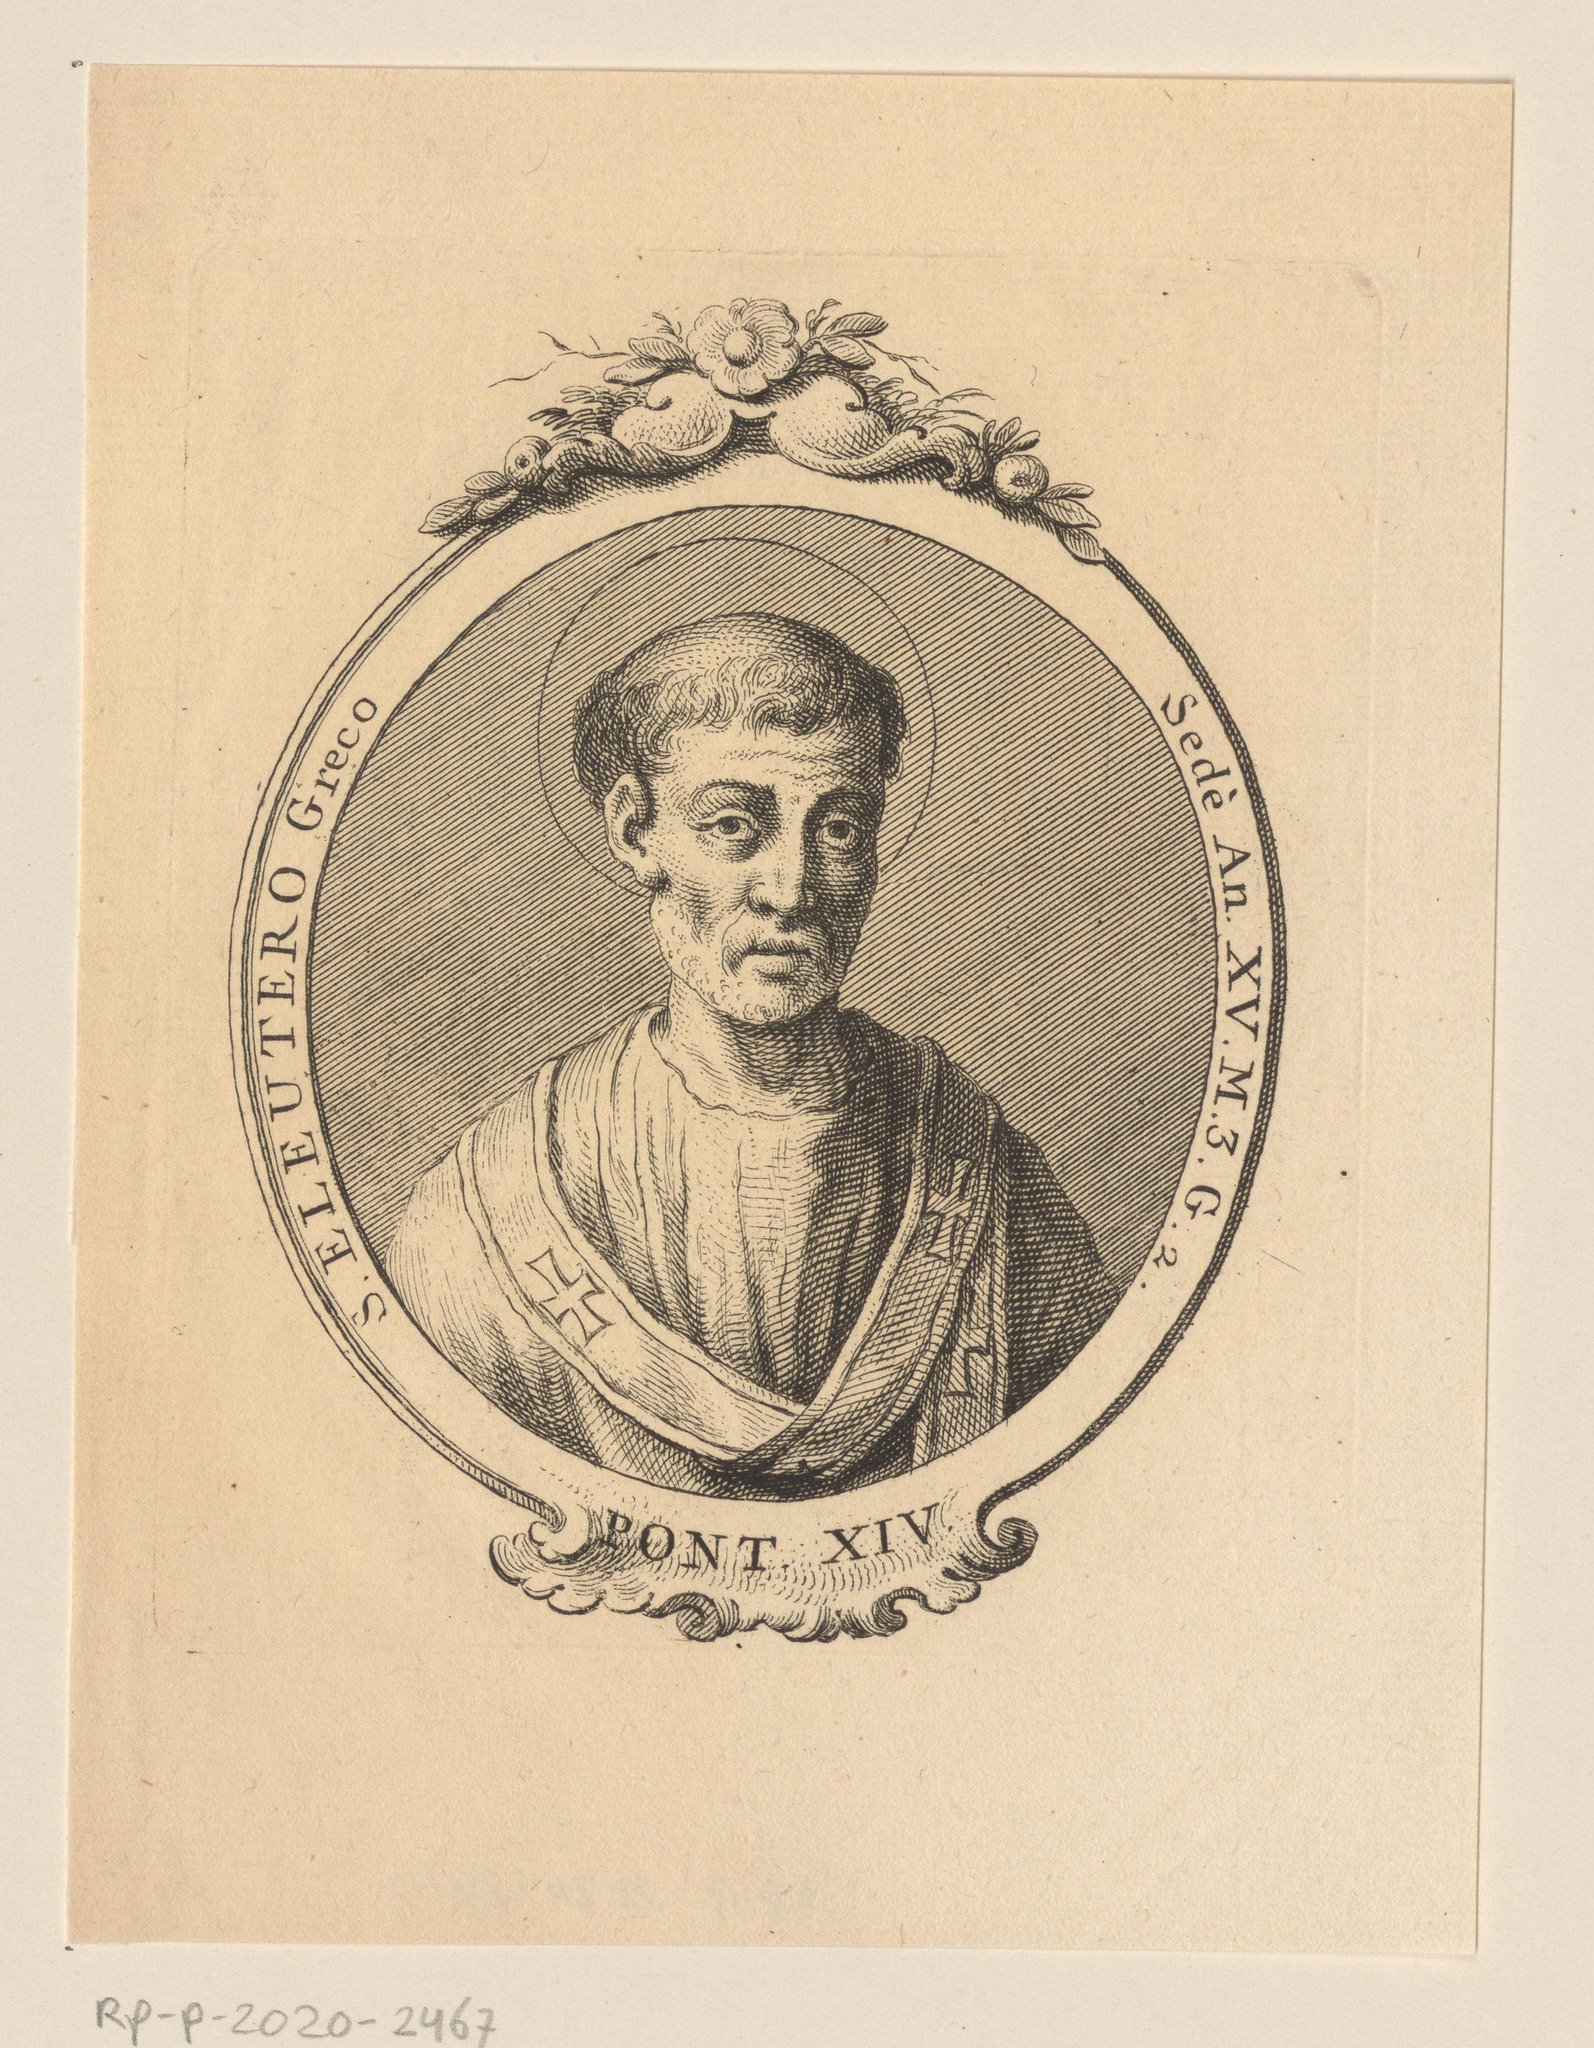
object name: print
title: Portret van paus Eleuterus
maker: Anonymous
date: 1650-1750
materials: paper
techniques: etching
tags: rome, historical persons, pope